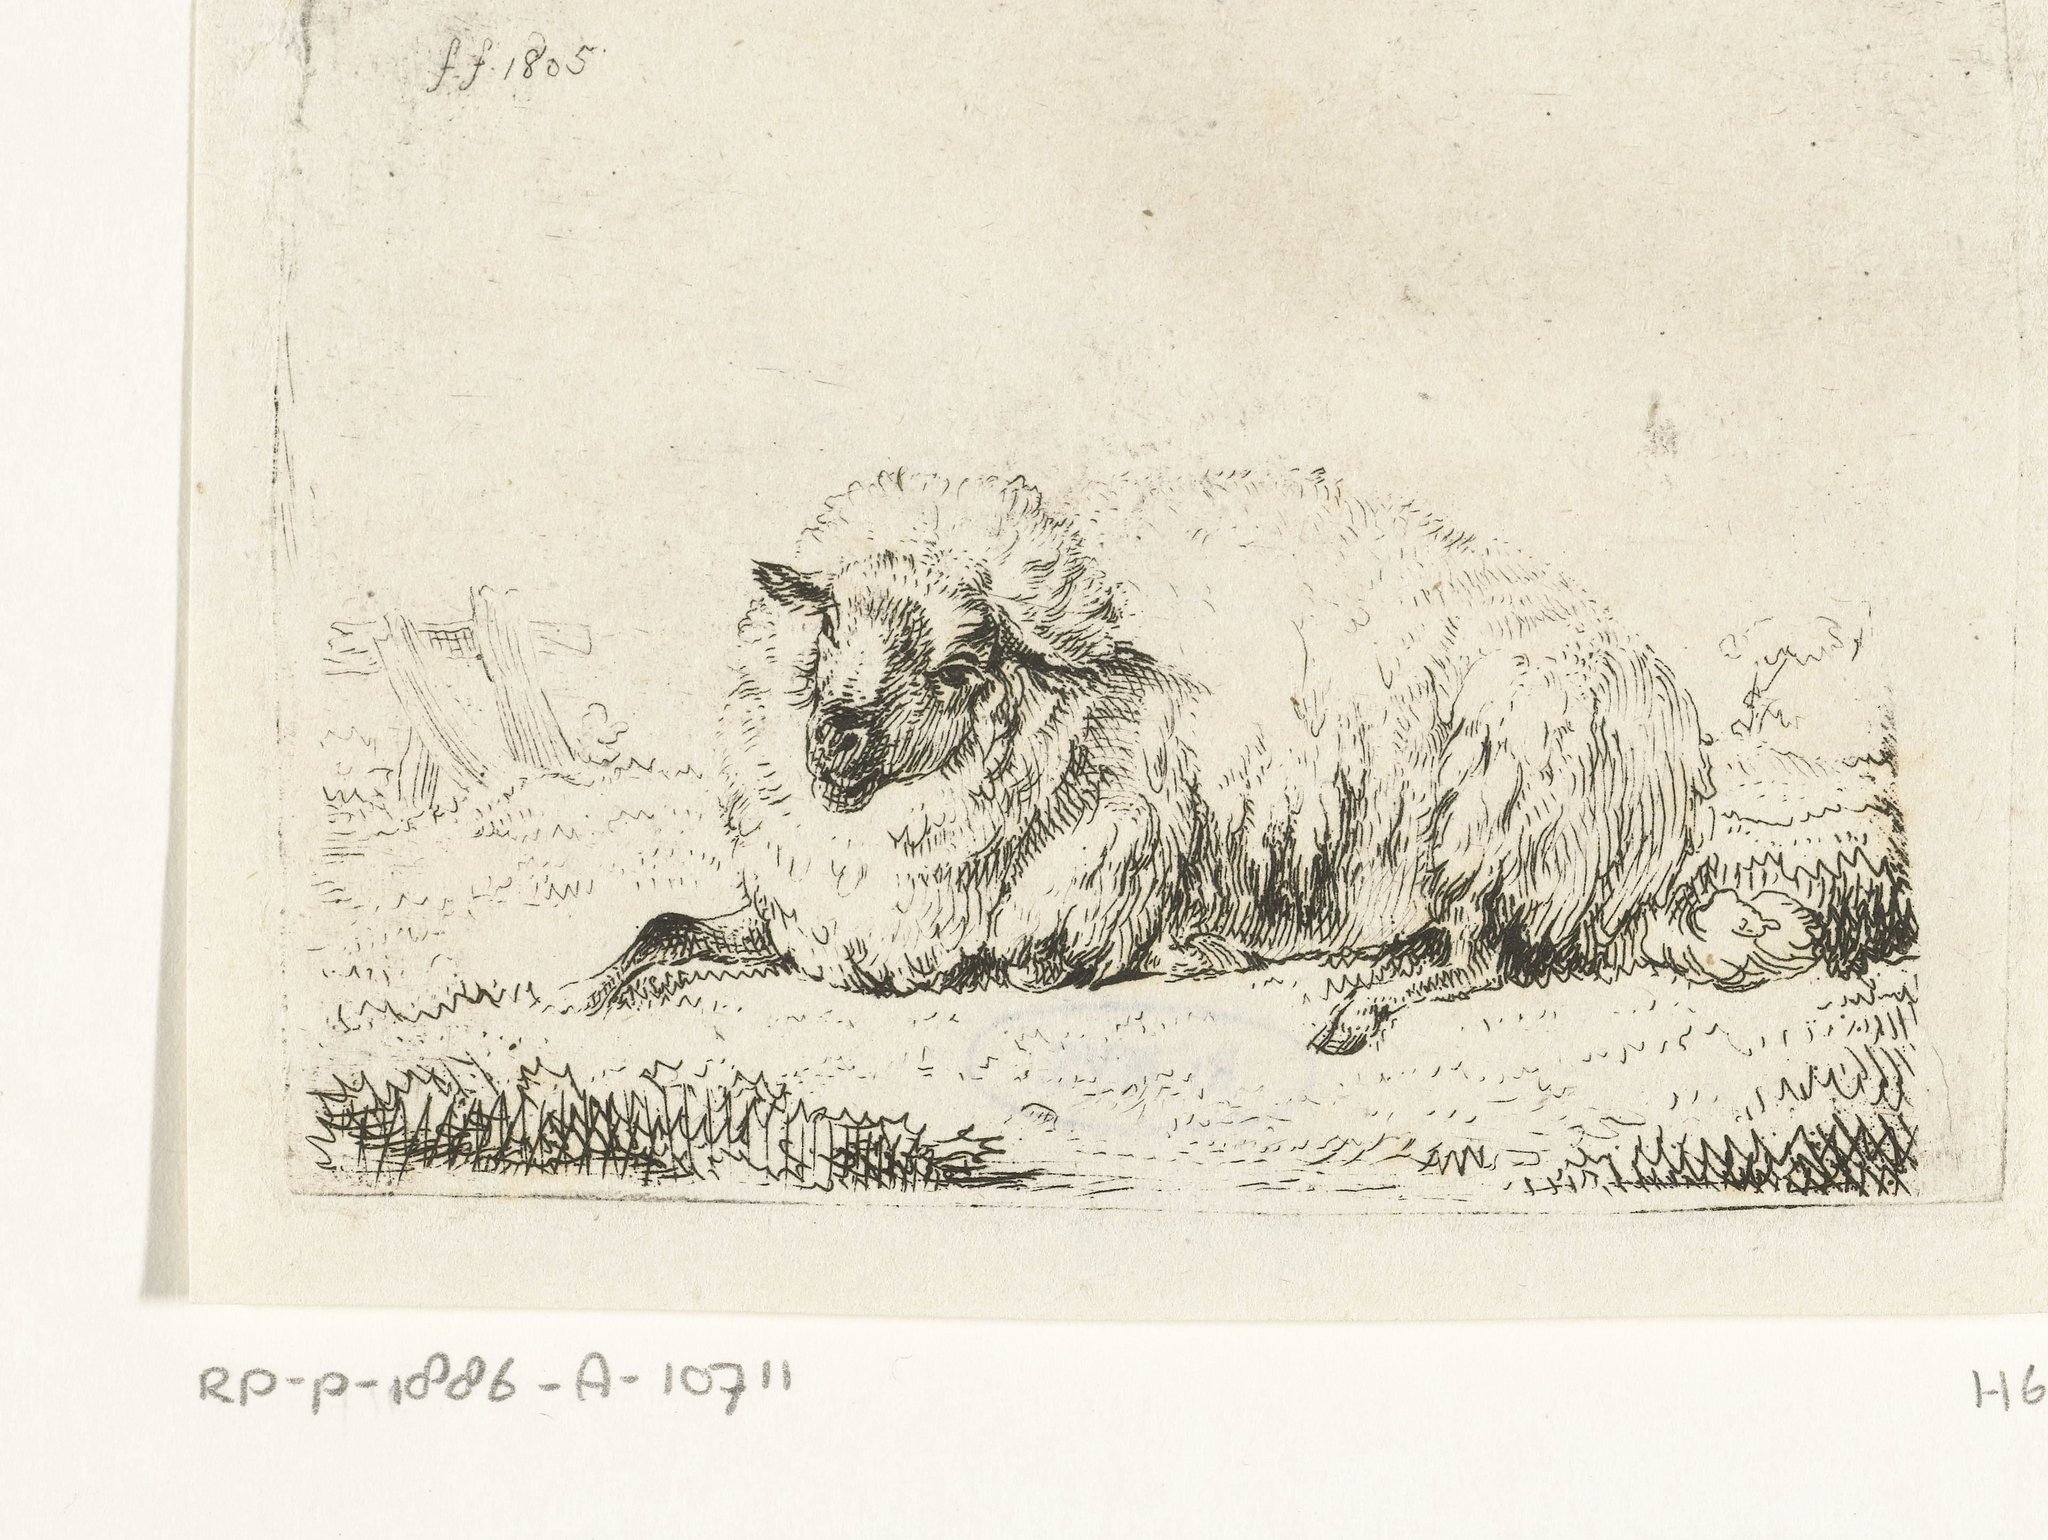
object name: print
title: Liggend schaap met dikke vacht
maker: frédéric théodore faber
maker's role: print maker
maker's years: 1782-1844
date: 1805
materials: paper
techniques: etching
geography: brussels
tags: sheep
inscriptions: collector's mark: Lugt 2228